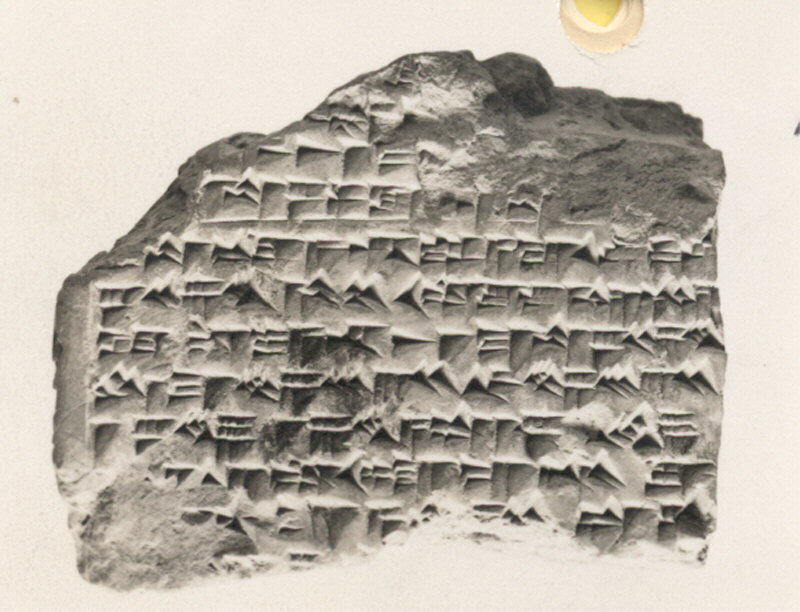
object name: cuneiform tablet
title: Cuneiform tablet: fragment of a mathematical problem text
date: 333-1 BCE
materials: clay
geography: mesopotamia